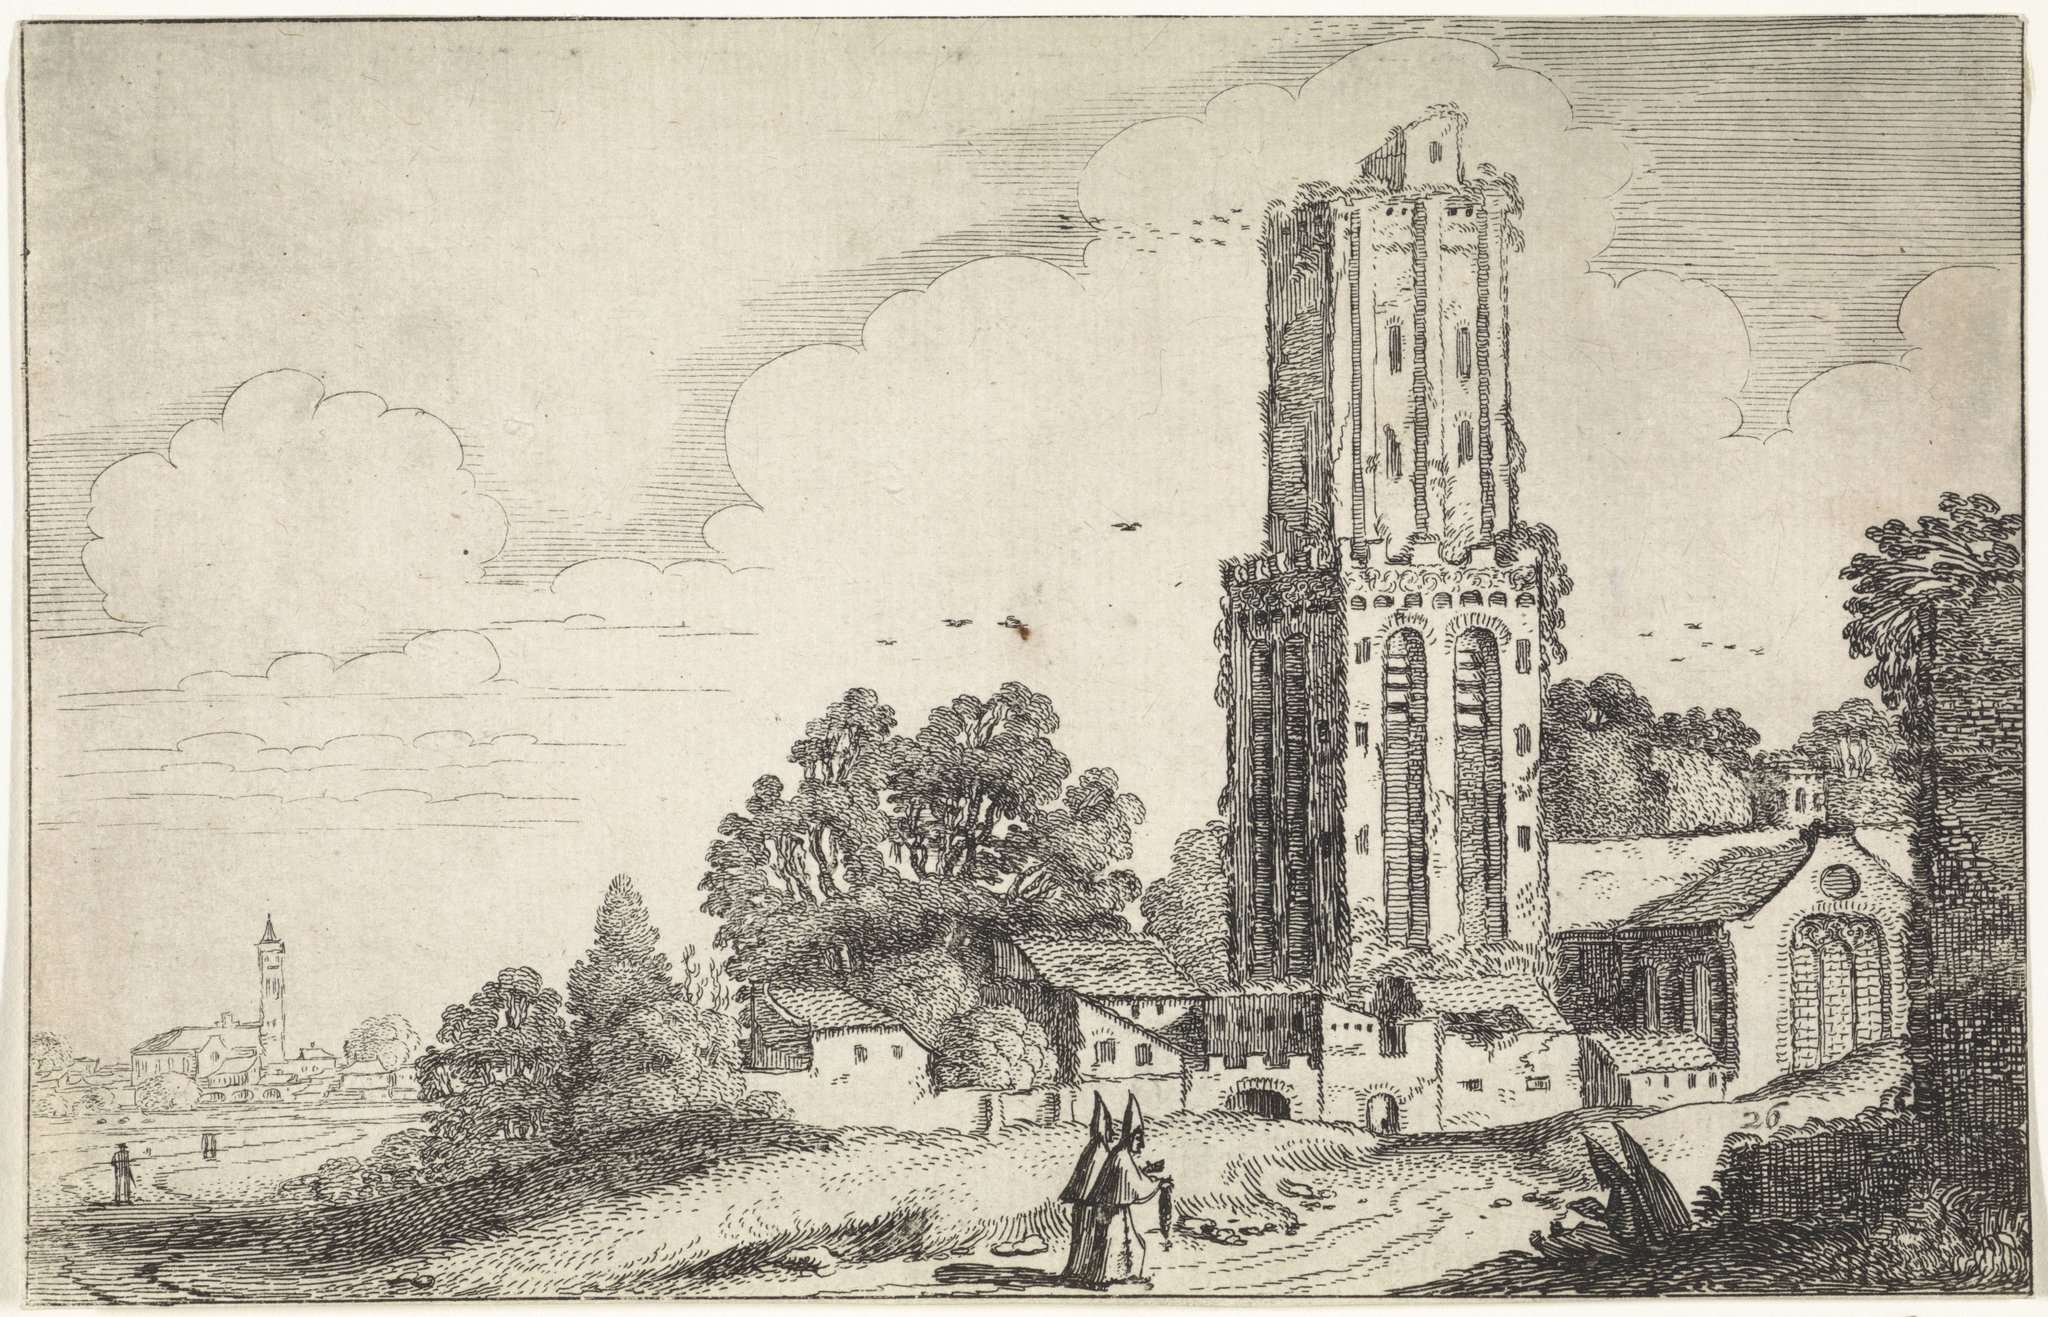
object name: print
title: Amenissimae aliquot requculae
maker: jan van de velde (ii)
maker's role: draughtsman, painter, print maker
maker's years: 1593-1641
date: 1616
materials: paper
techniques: etching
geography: northern netherlands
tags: church (exterior), landscape with ruins, monk(s), friar(s)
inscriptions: collector's mark: Lugt 964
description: Geestelijken op een pad bij een vervallen kerktoren. Links op de achtergrond een dorp. Zesentwintigste prent van een serie van in totaal 52 prenten met landschappen, verdeeld over twee delen van elk 26 prenten.